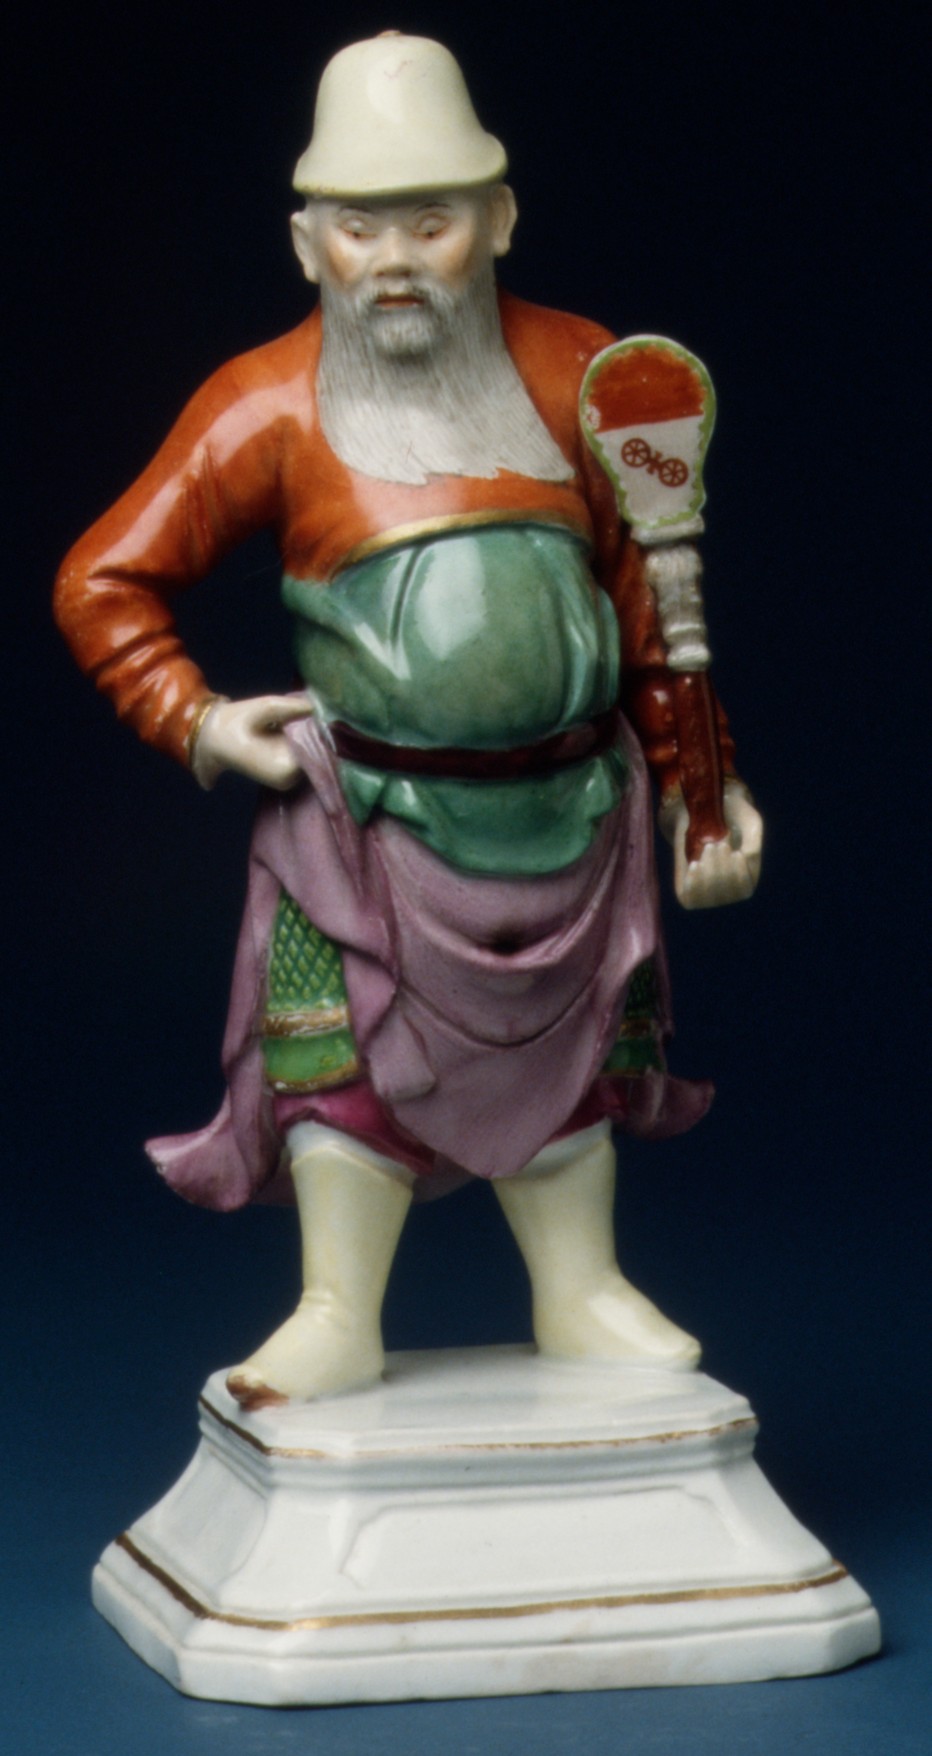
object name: figure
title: Asian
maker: höchst manufactory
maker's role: manufactory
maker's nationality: german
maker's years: 1746-1796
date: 1750-1755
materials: hard paste porcelain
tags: men